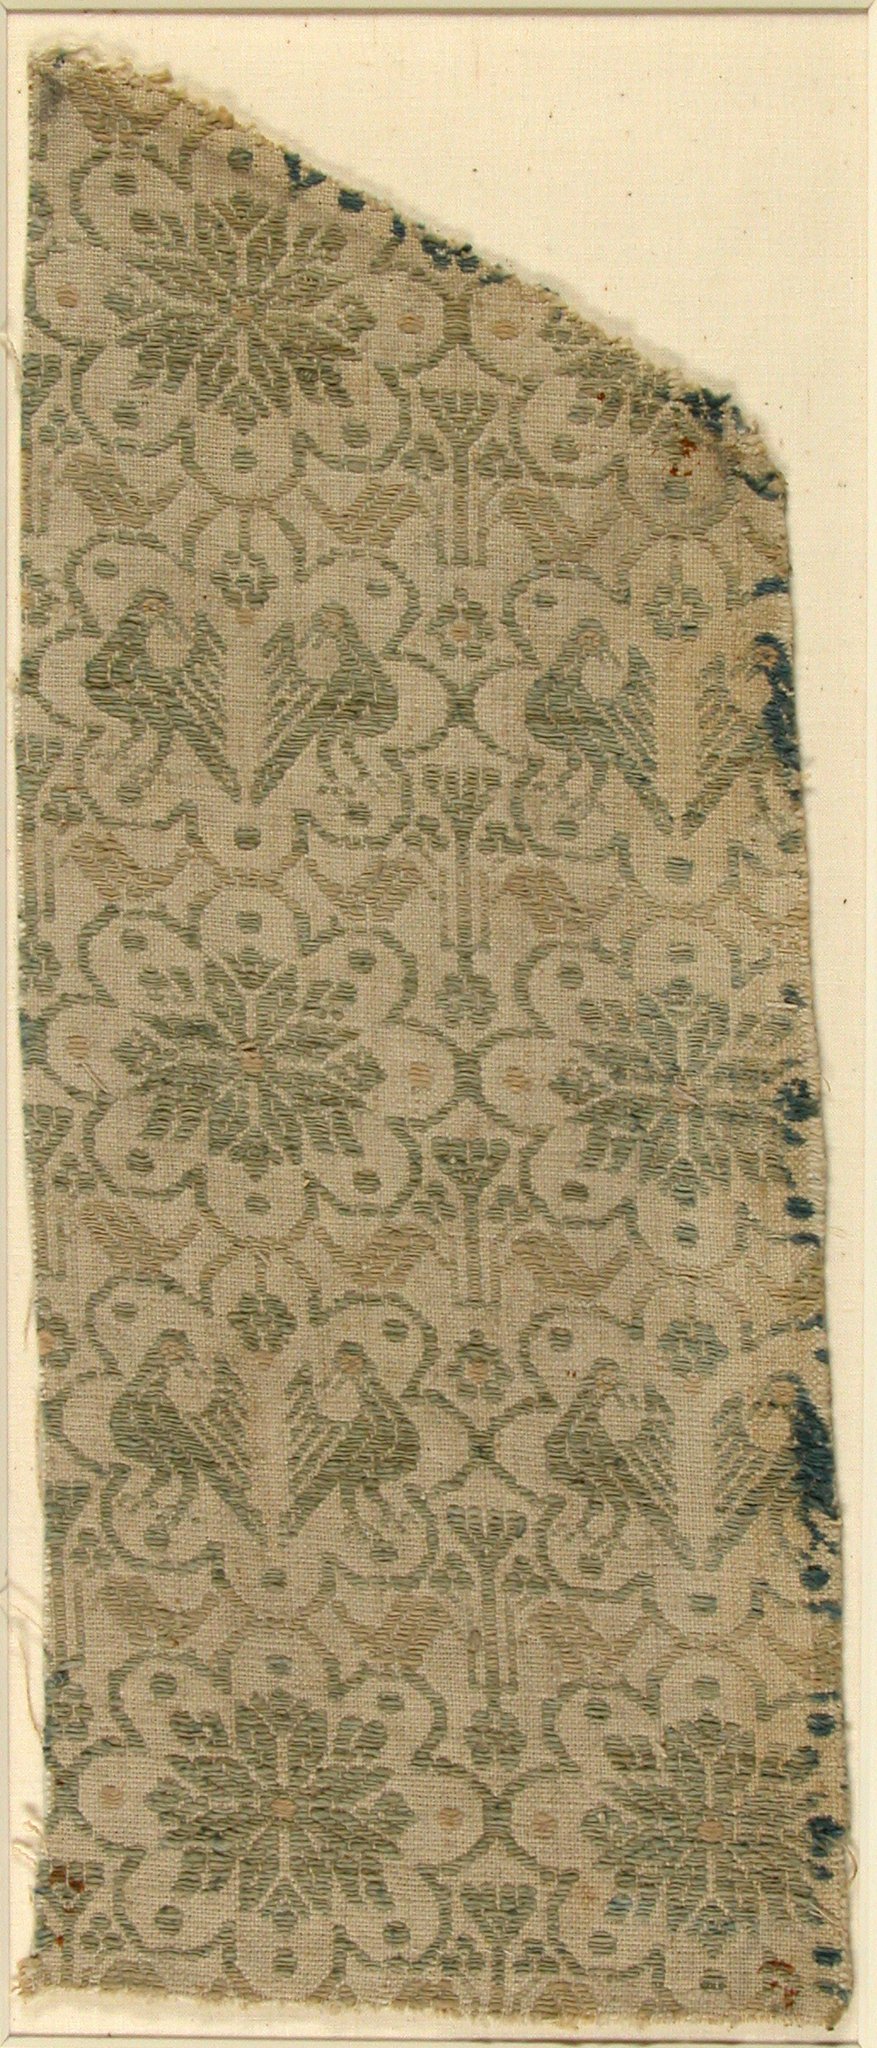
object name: textile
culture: italian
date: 1400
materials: linen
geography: italy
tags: birds,flowers